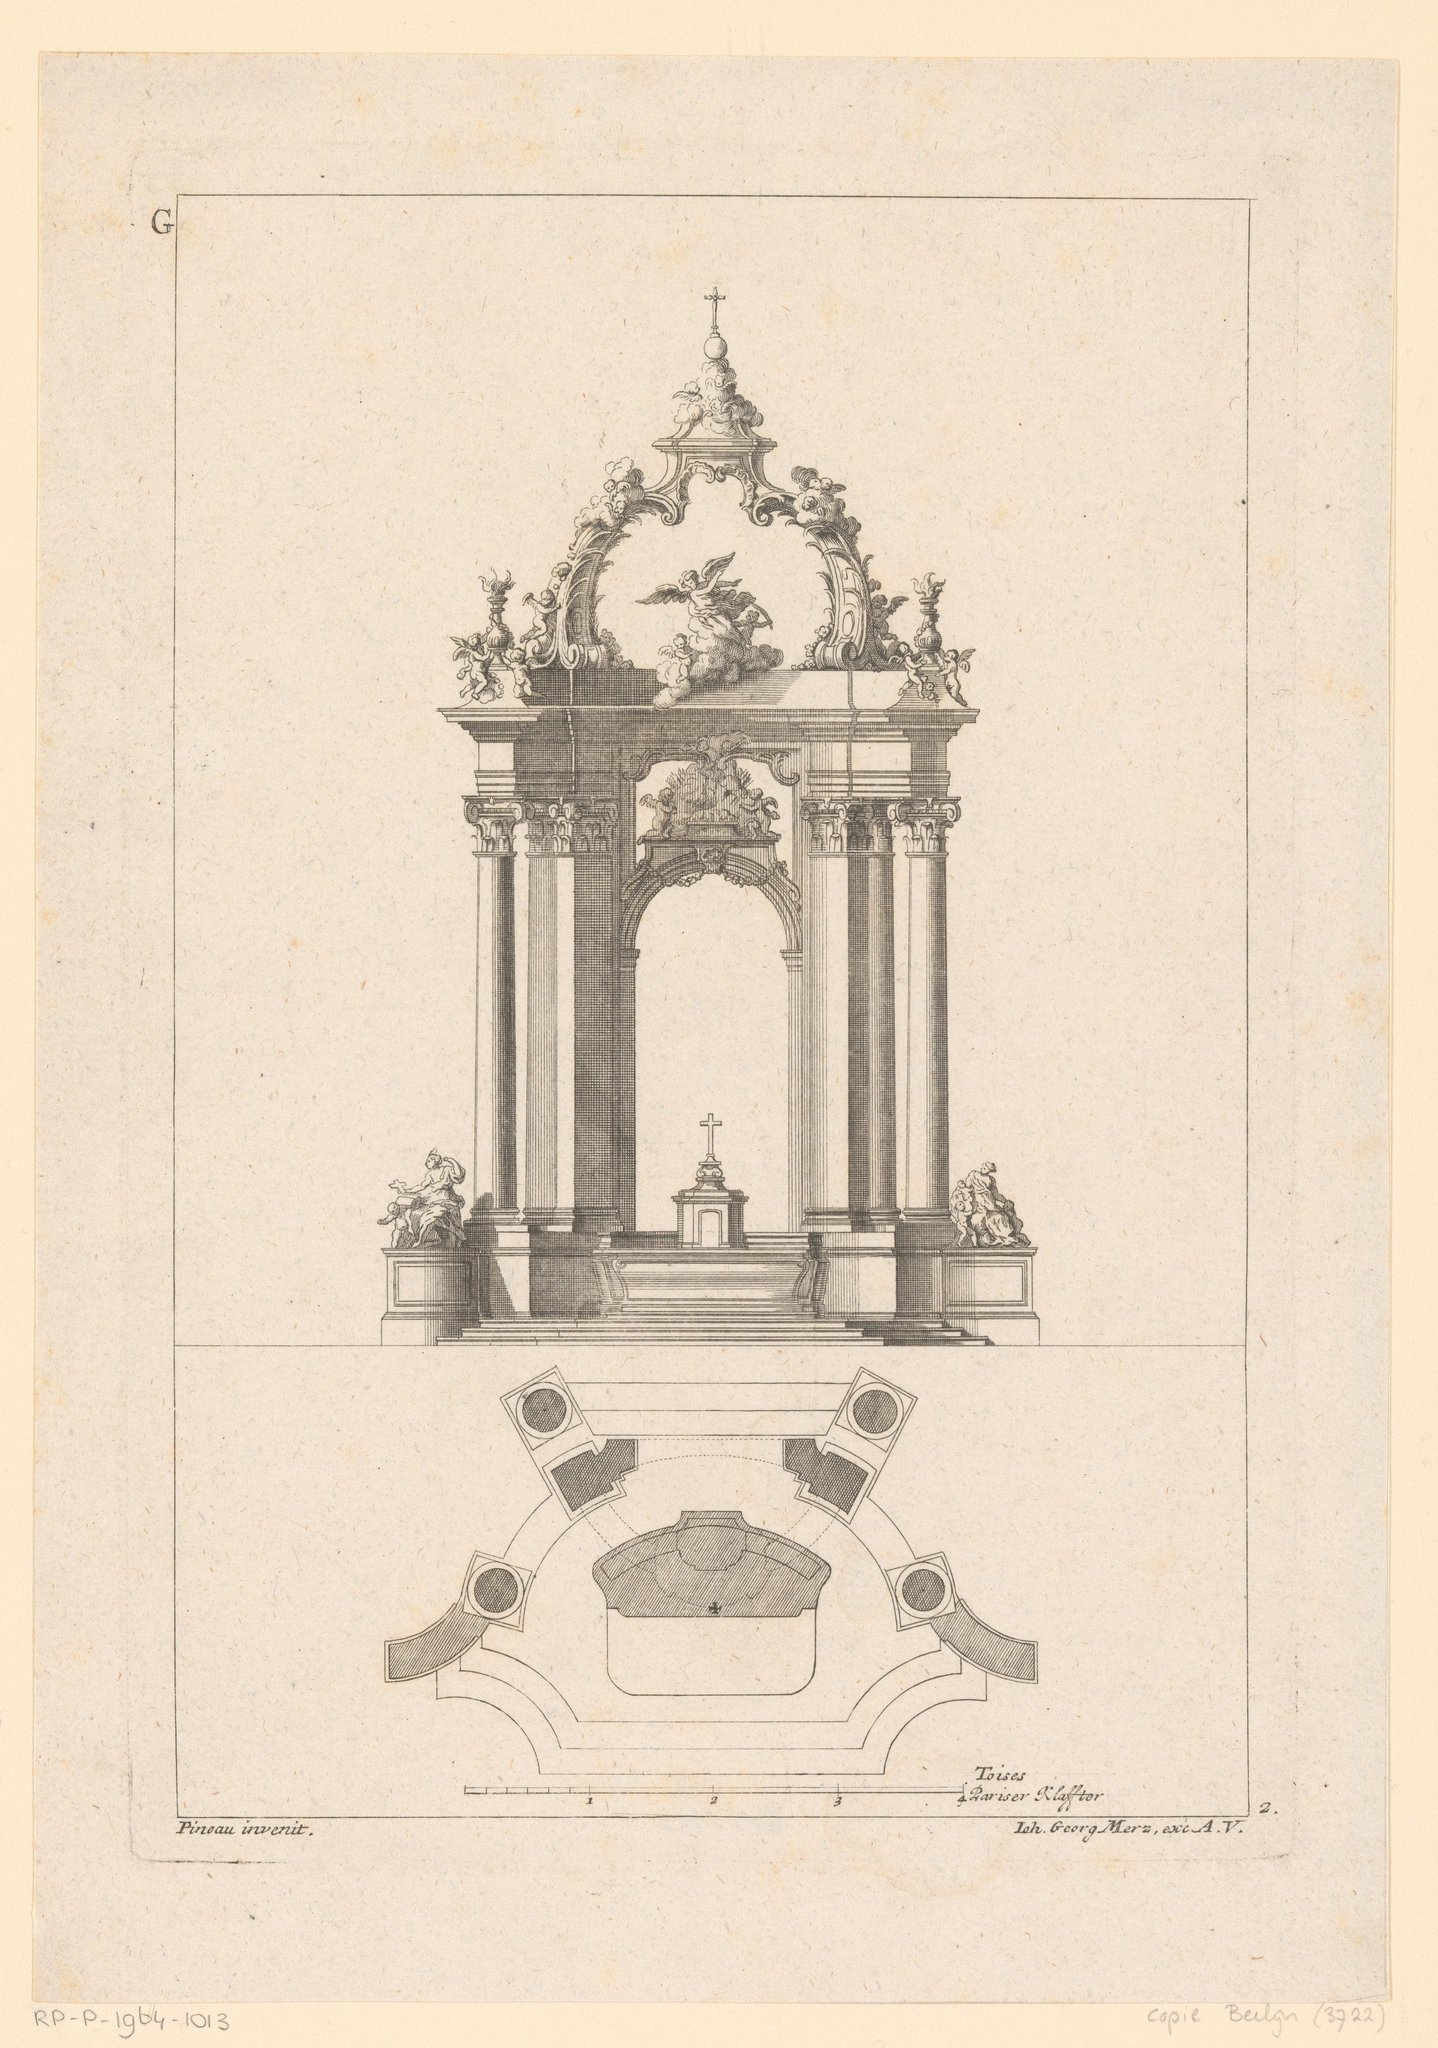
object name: ornament print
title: Baldakijn en altaar met kruis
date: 1704-1762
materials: paper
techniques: engraving, etching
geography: augsburg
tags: canopy, baldachin, the cross ~ symbols of christ, altar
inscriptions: collector's mark: Lugt 2228, collector's mark: Lugt 2760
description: Vooraanzicht en plattegrond van een altaar en baldakijn. Onder een baldakijn met engelen en putti staat een altaar met een kruis. Links en rechts op een voetstuk beelden van vrouwen met putti.